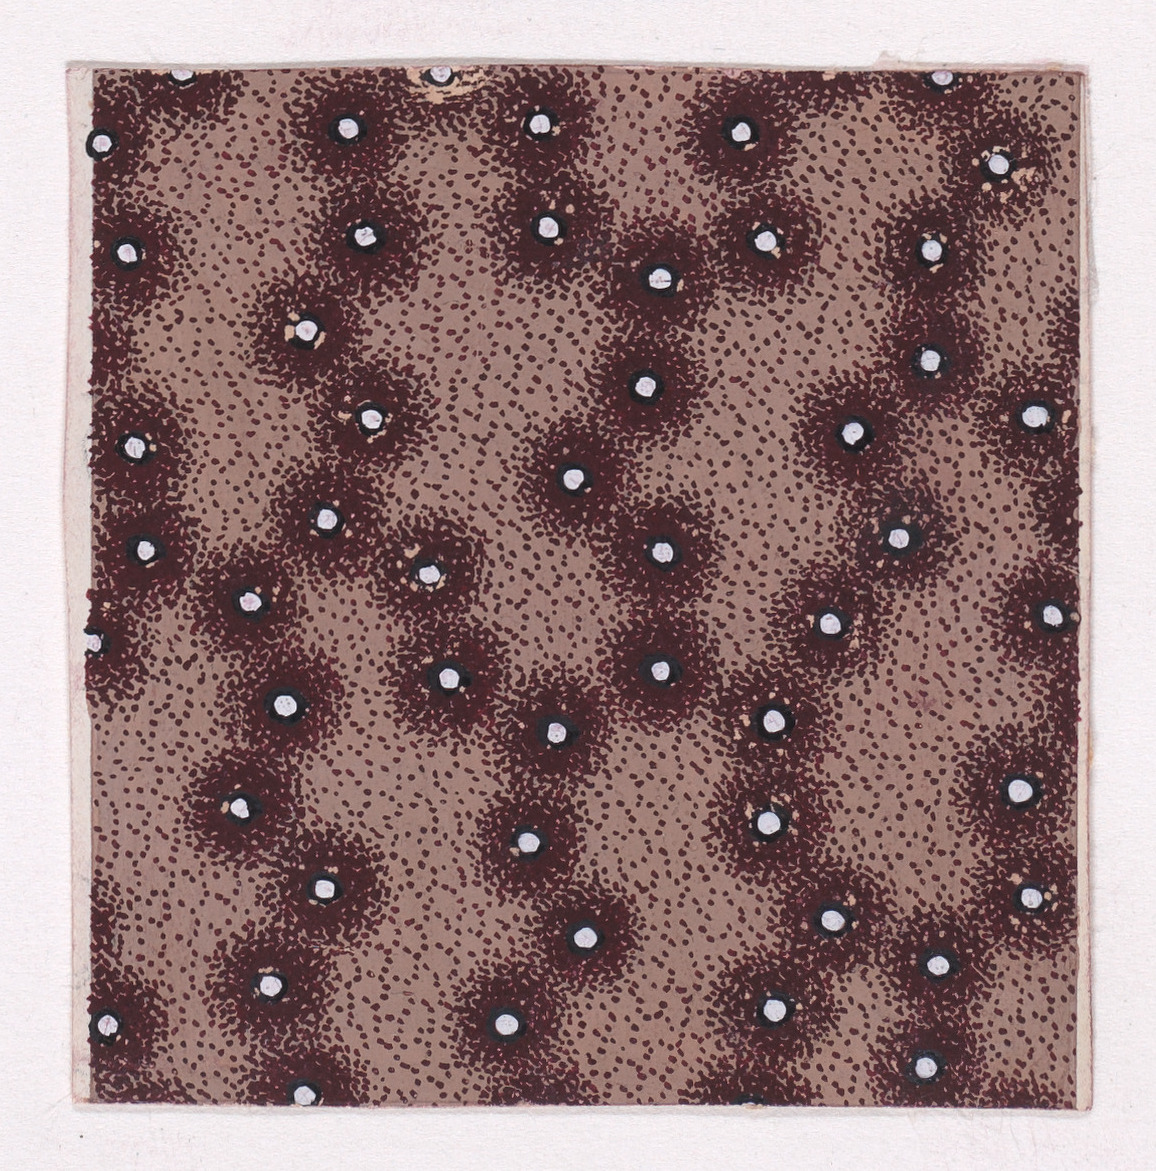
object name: drawing ornament architecture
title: Textile Design with an Interlacing Pattern of Circles with Pearls over a Stippled Background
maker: anonymous, alsatian, 19th century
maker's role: artist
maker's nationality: alsatian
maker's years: 1800-1900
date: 1840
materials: gouache